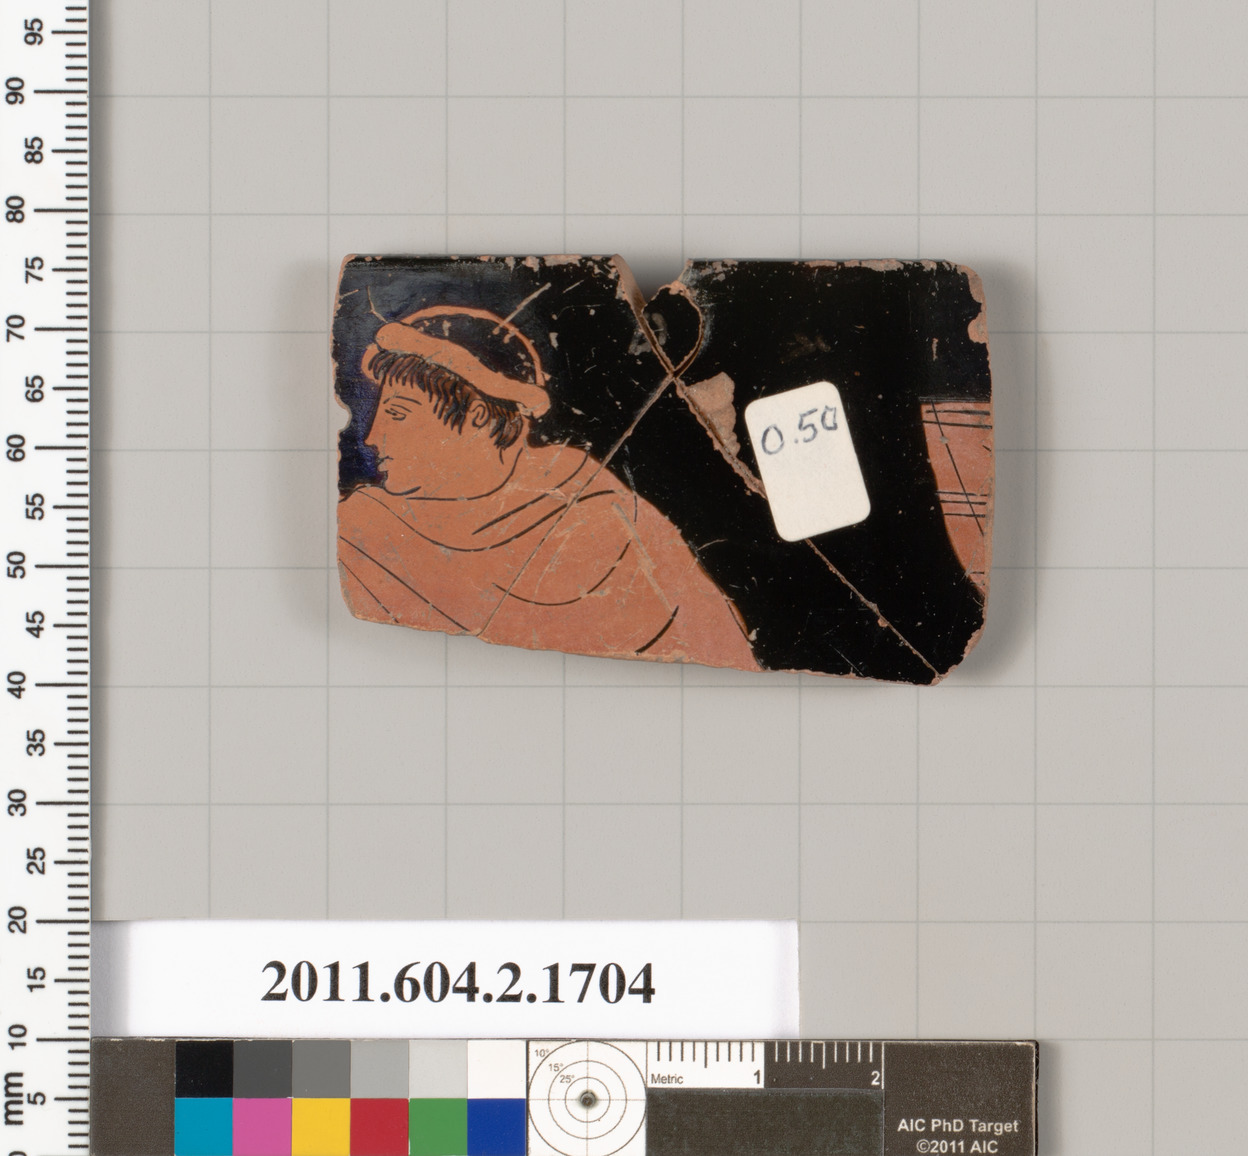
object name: skyphos fragment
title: Terracotta rim fragment of a skyphos (deep drinking cup)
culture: greek, attic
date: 475-451 BCE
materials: terracotta